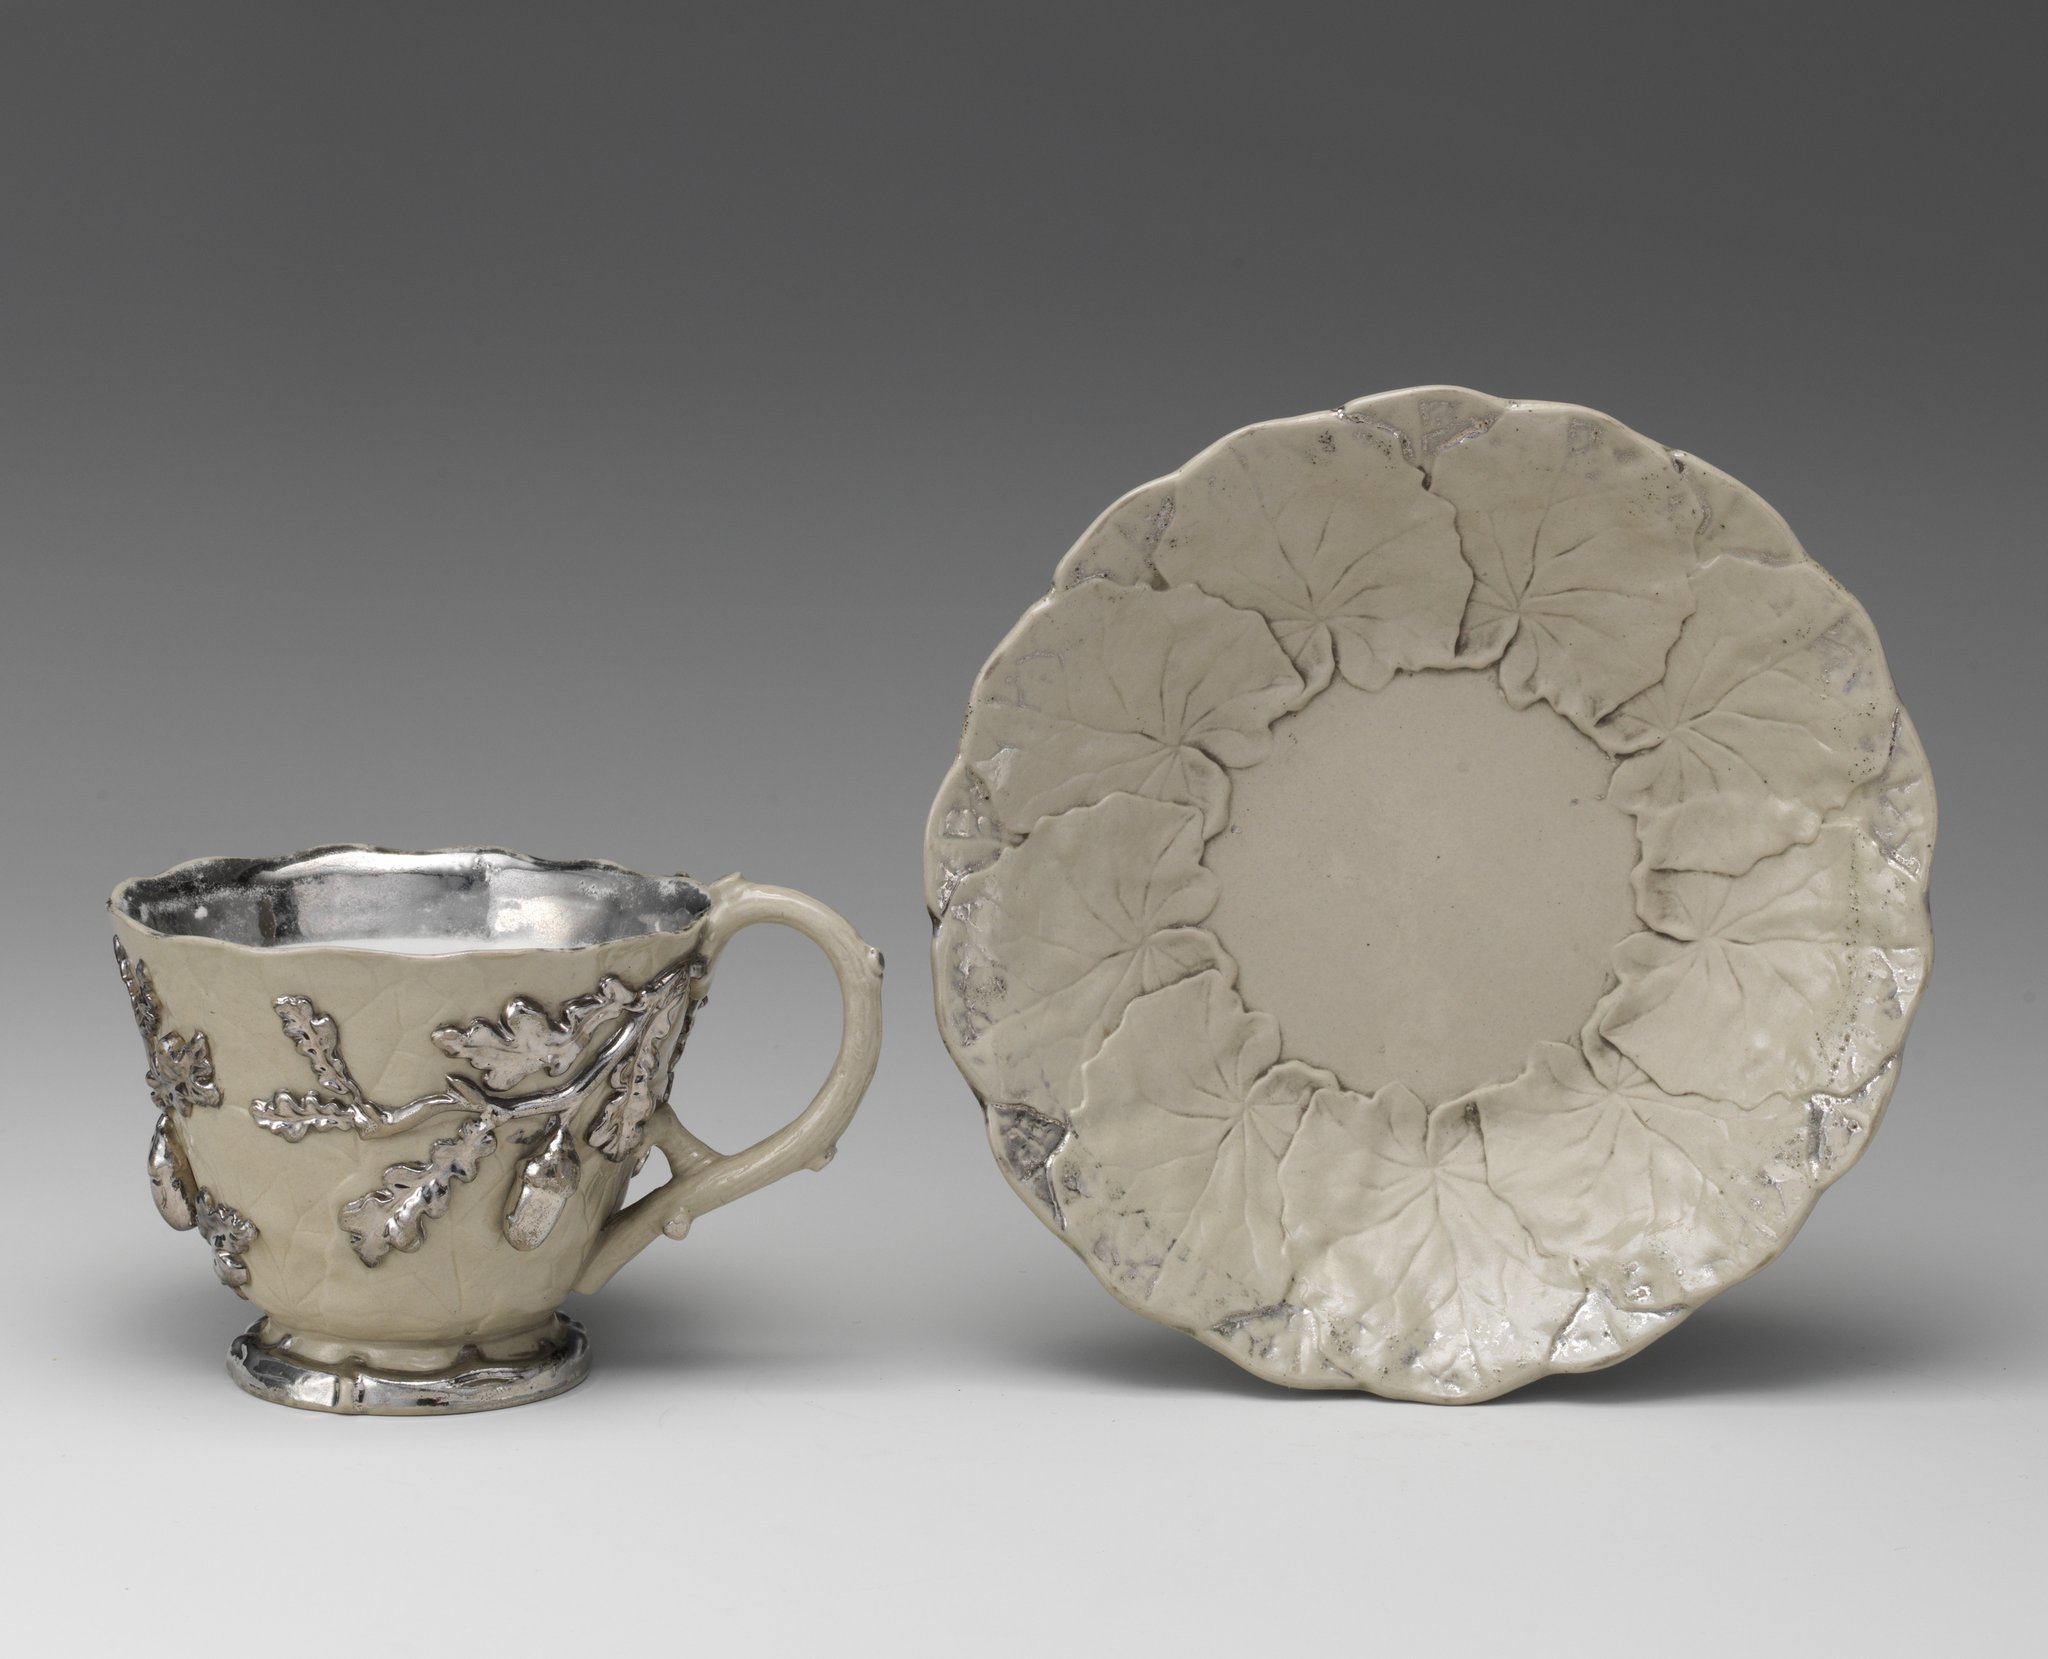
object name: cup and saucer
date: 1830-1840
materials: creamware, pottery